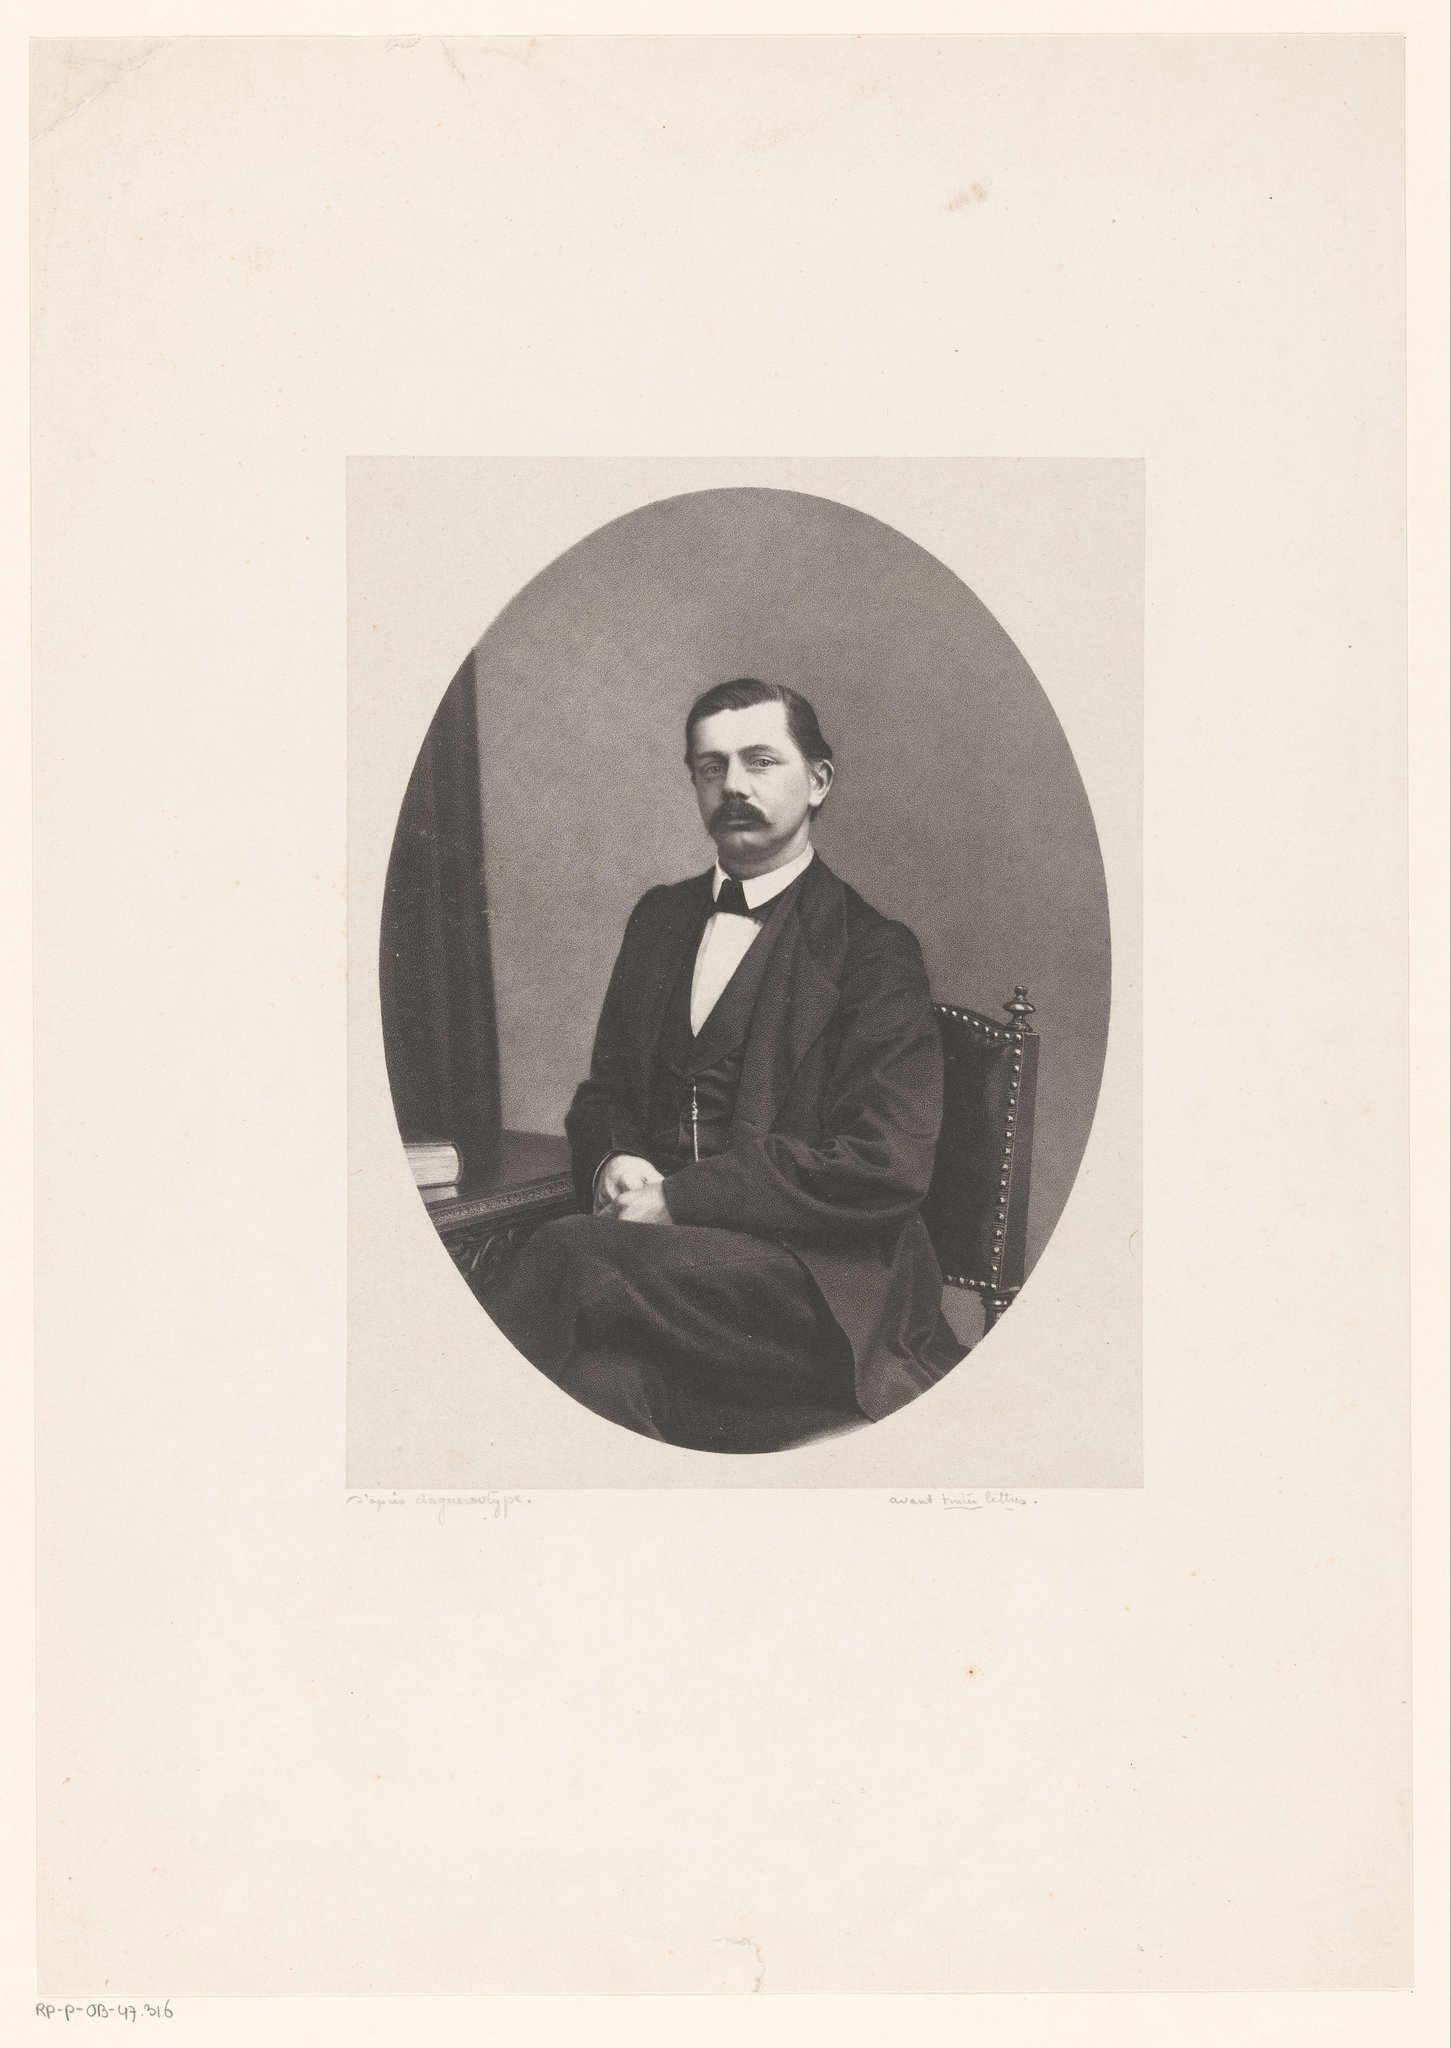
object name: print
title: Portret van een onbekende man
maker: Anonymous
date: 1809-1899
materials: paper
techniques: lithograph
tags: historical persons (+ three-quarter length portrait)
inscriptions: collector's mark: Lugt 2228, inscription: ‘D'après daguerrotype’, inscription: ‘avant toutes lettres.’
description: De man zit op een stoel naast een tafel. Op de tafel ligt een boek.